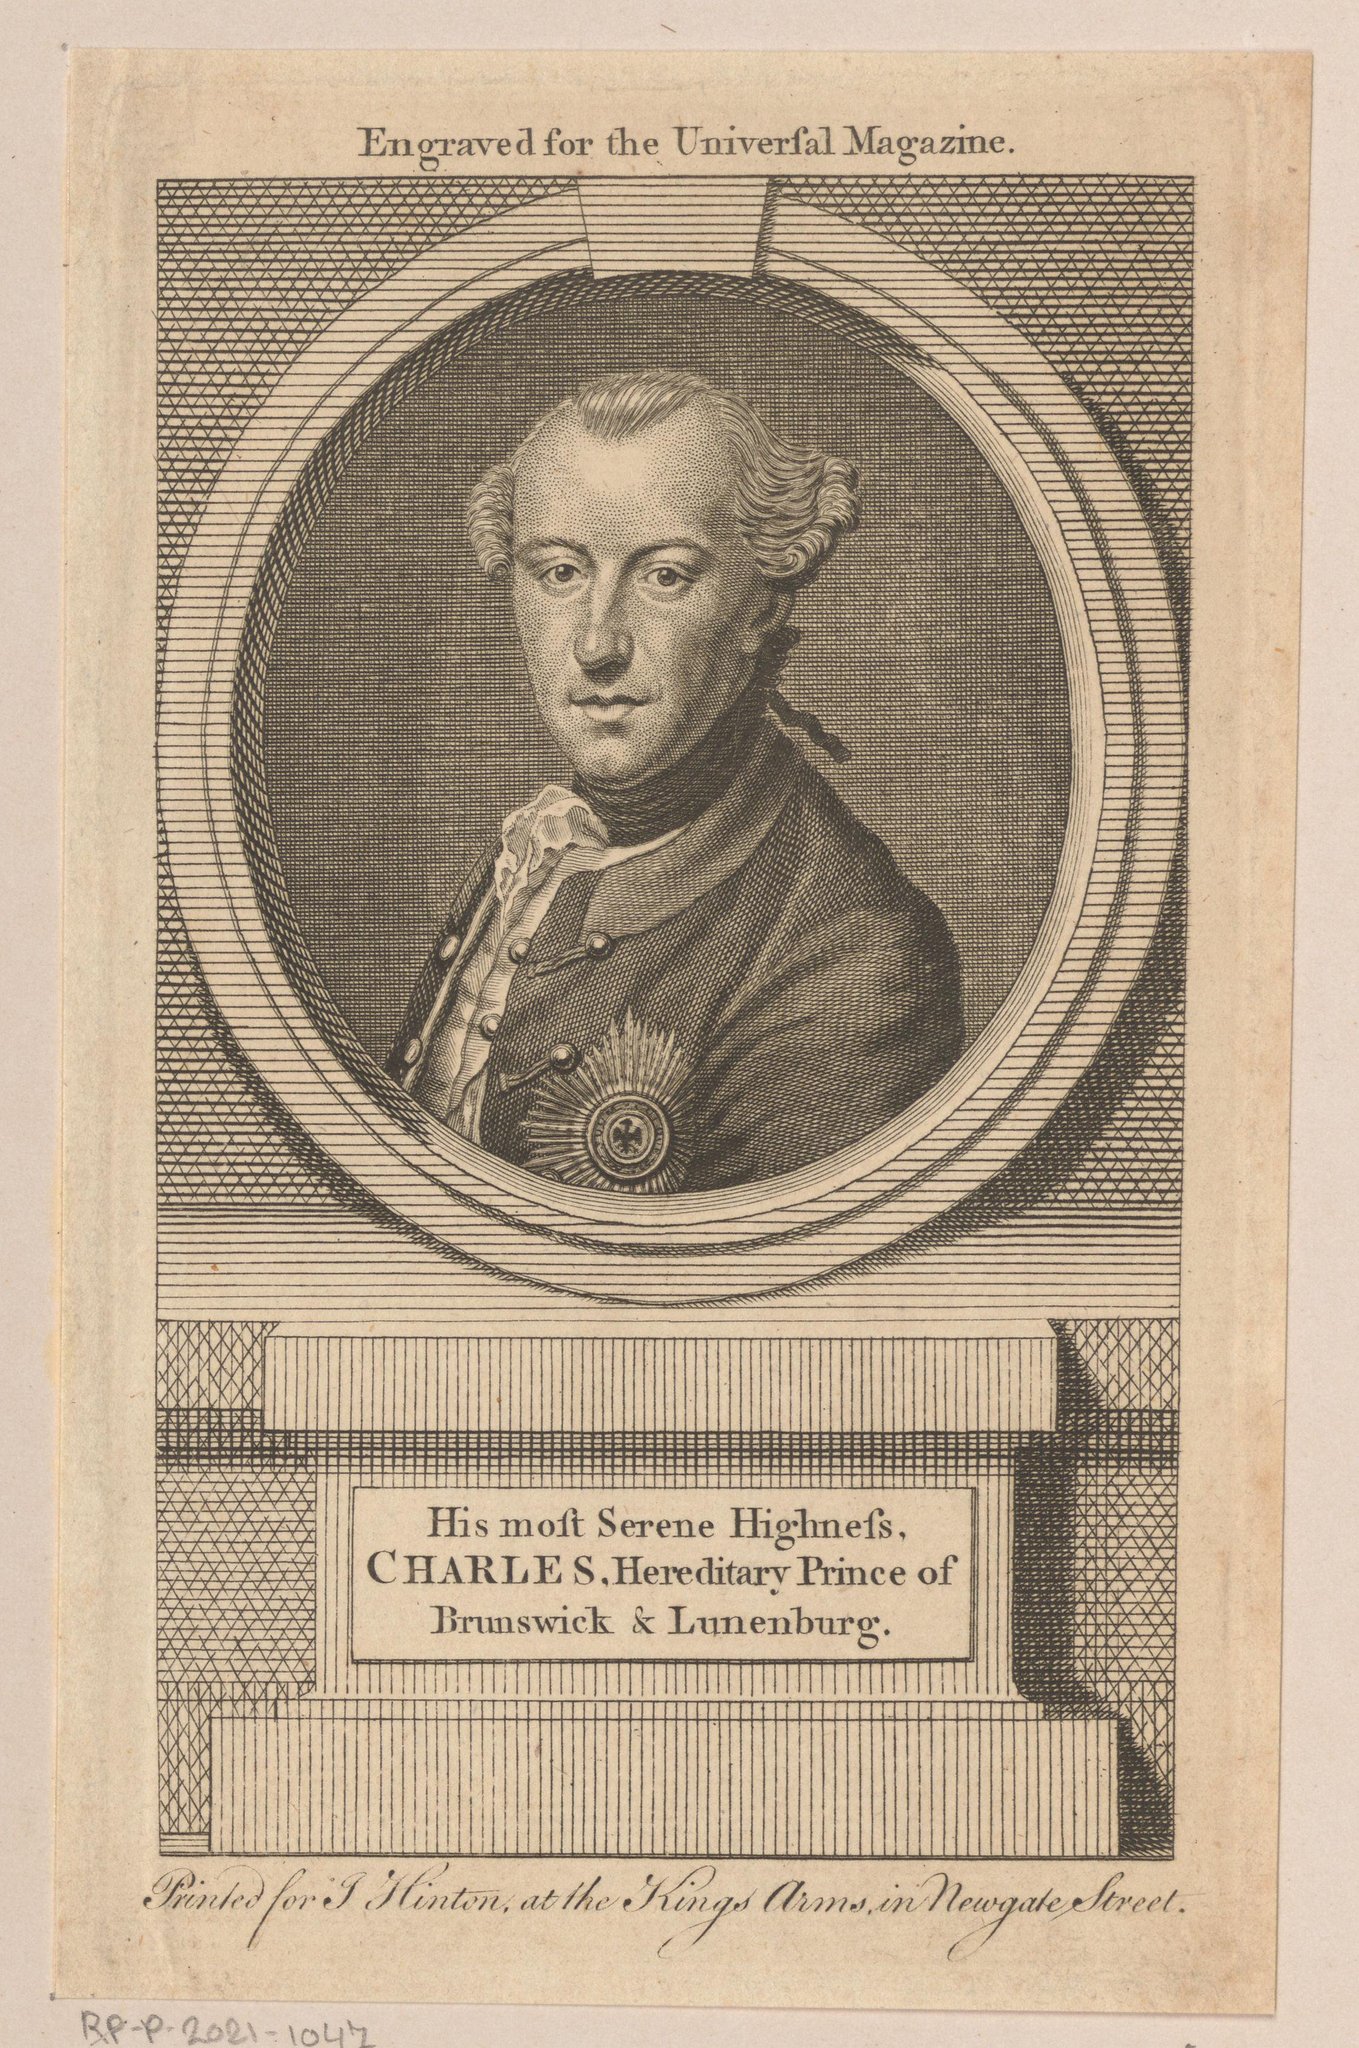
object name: print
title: Portret van Karel Willem Ferdinand hertog van Brunswijk-Wolfenbüttel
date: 1747-1781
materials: paper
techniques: engraving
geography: london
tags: historical persons, medals and other marks of military honour, ruler, sovereign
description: Prent uit: Universal Magazine, uitgegeven tussen 1747-1814.